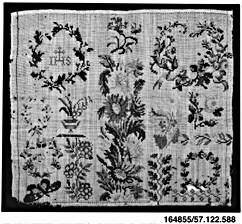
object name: sampler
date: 1801-1900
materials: canvas, silk, wool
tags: flowers